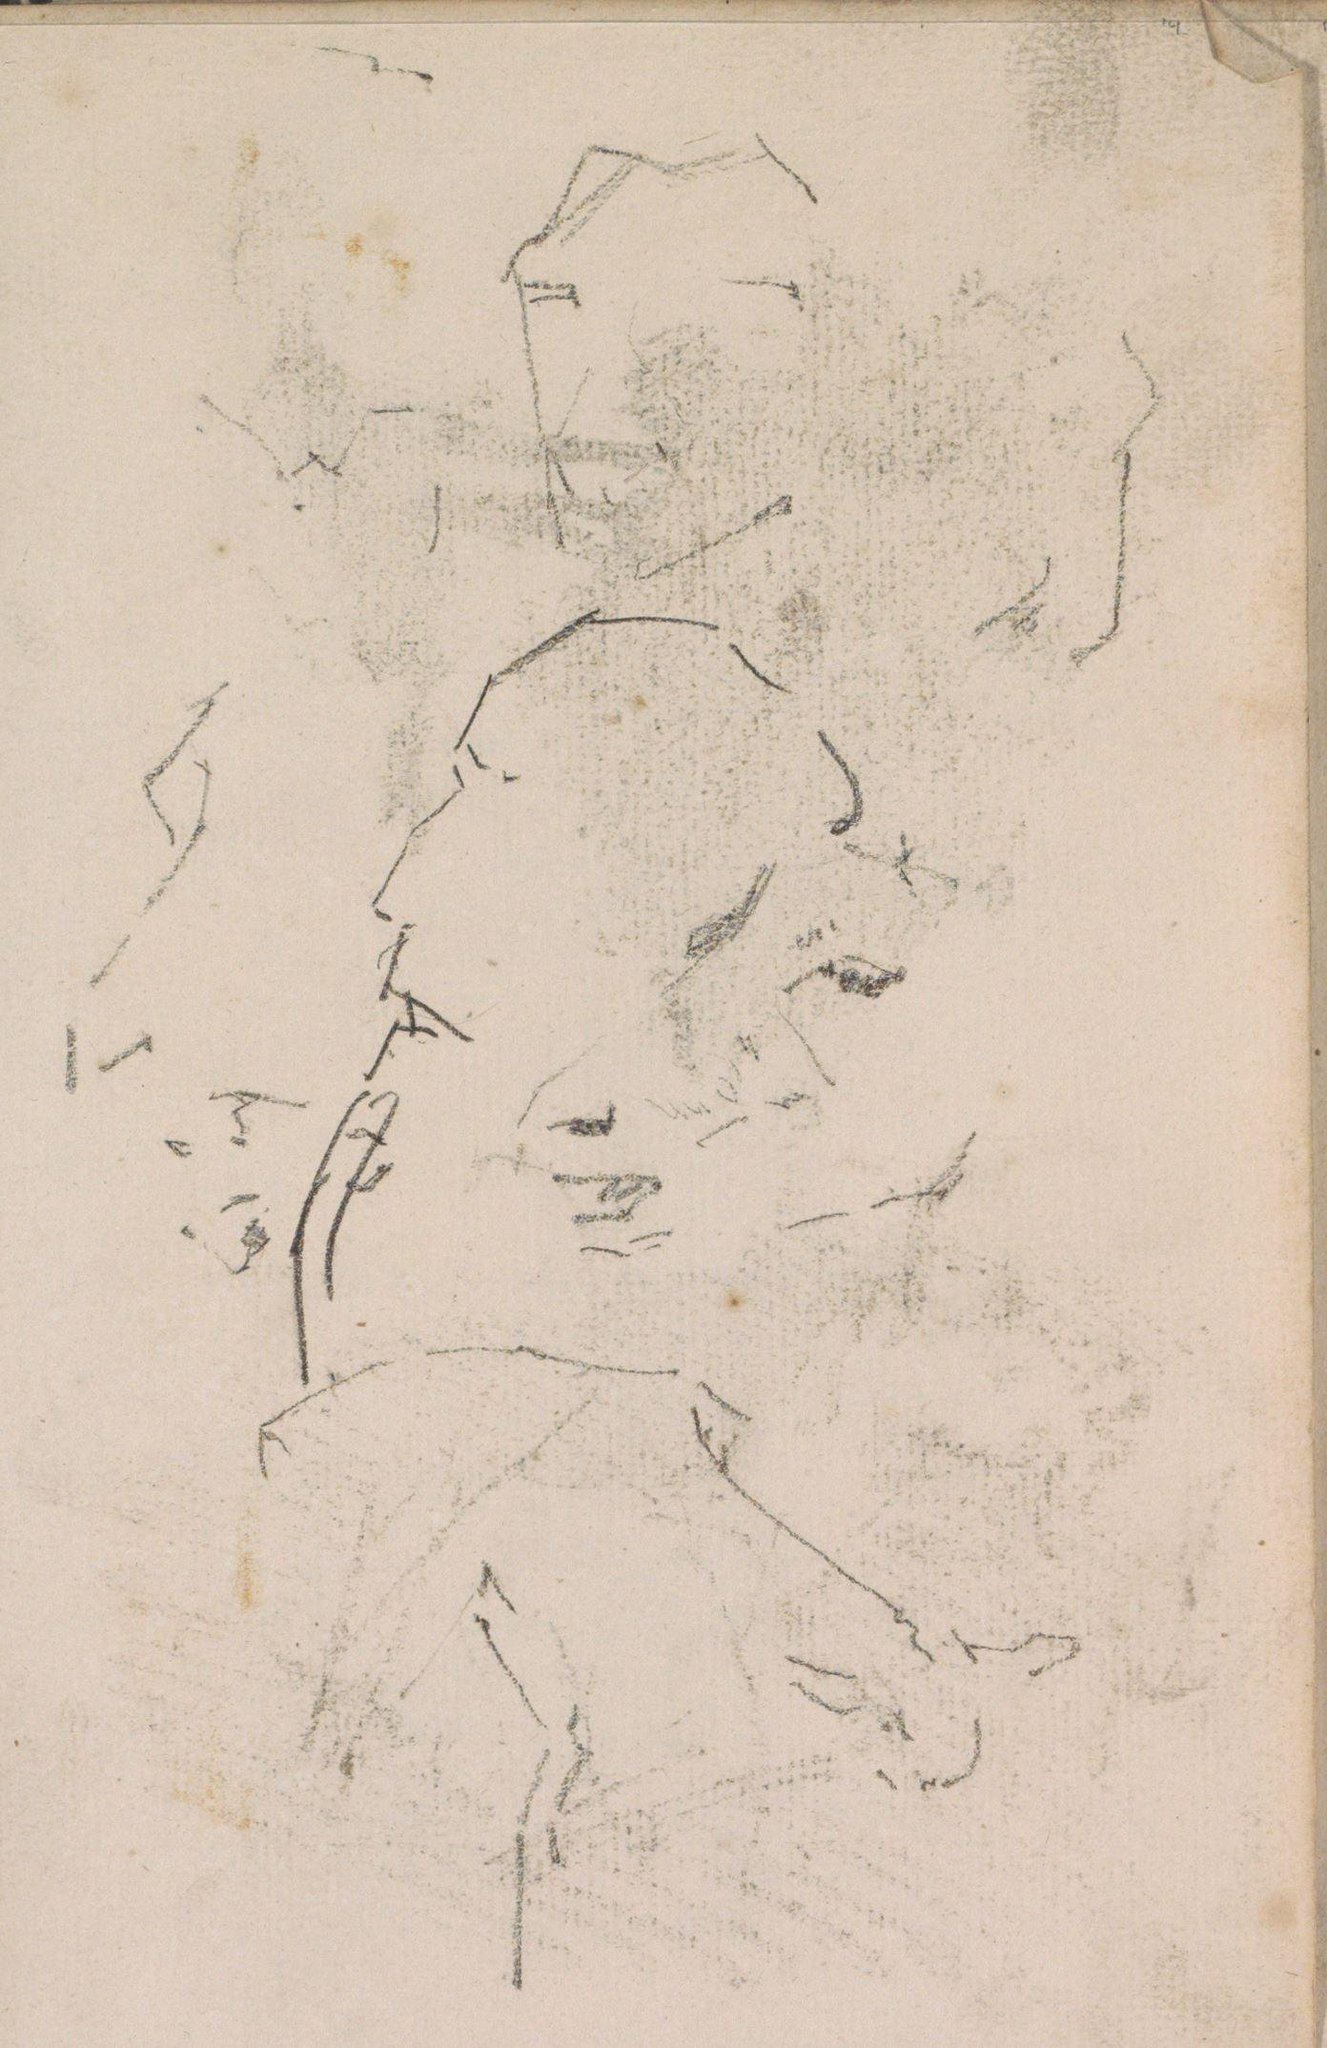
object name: sketchbook leaf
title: Studieblad met een hoofd en geiten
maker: george hendrik breitner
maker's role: draughtsman, painter, print maker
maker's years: 1857-1923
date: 1880-1882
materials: chalk, paper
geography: the hague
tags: head (human), goat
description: Pagina 14 uit een schetsboek met 29 bladen.